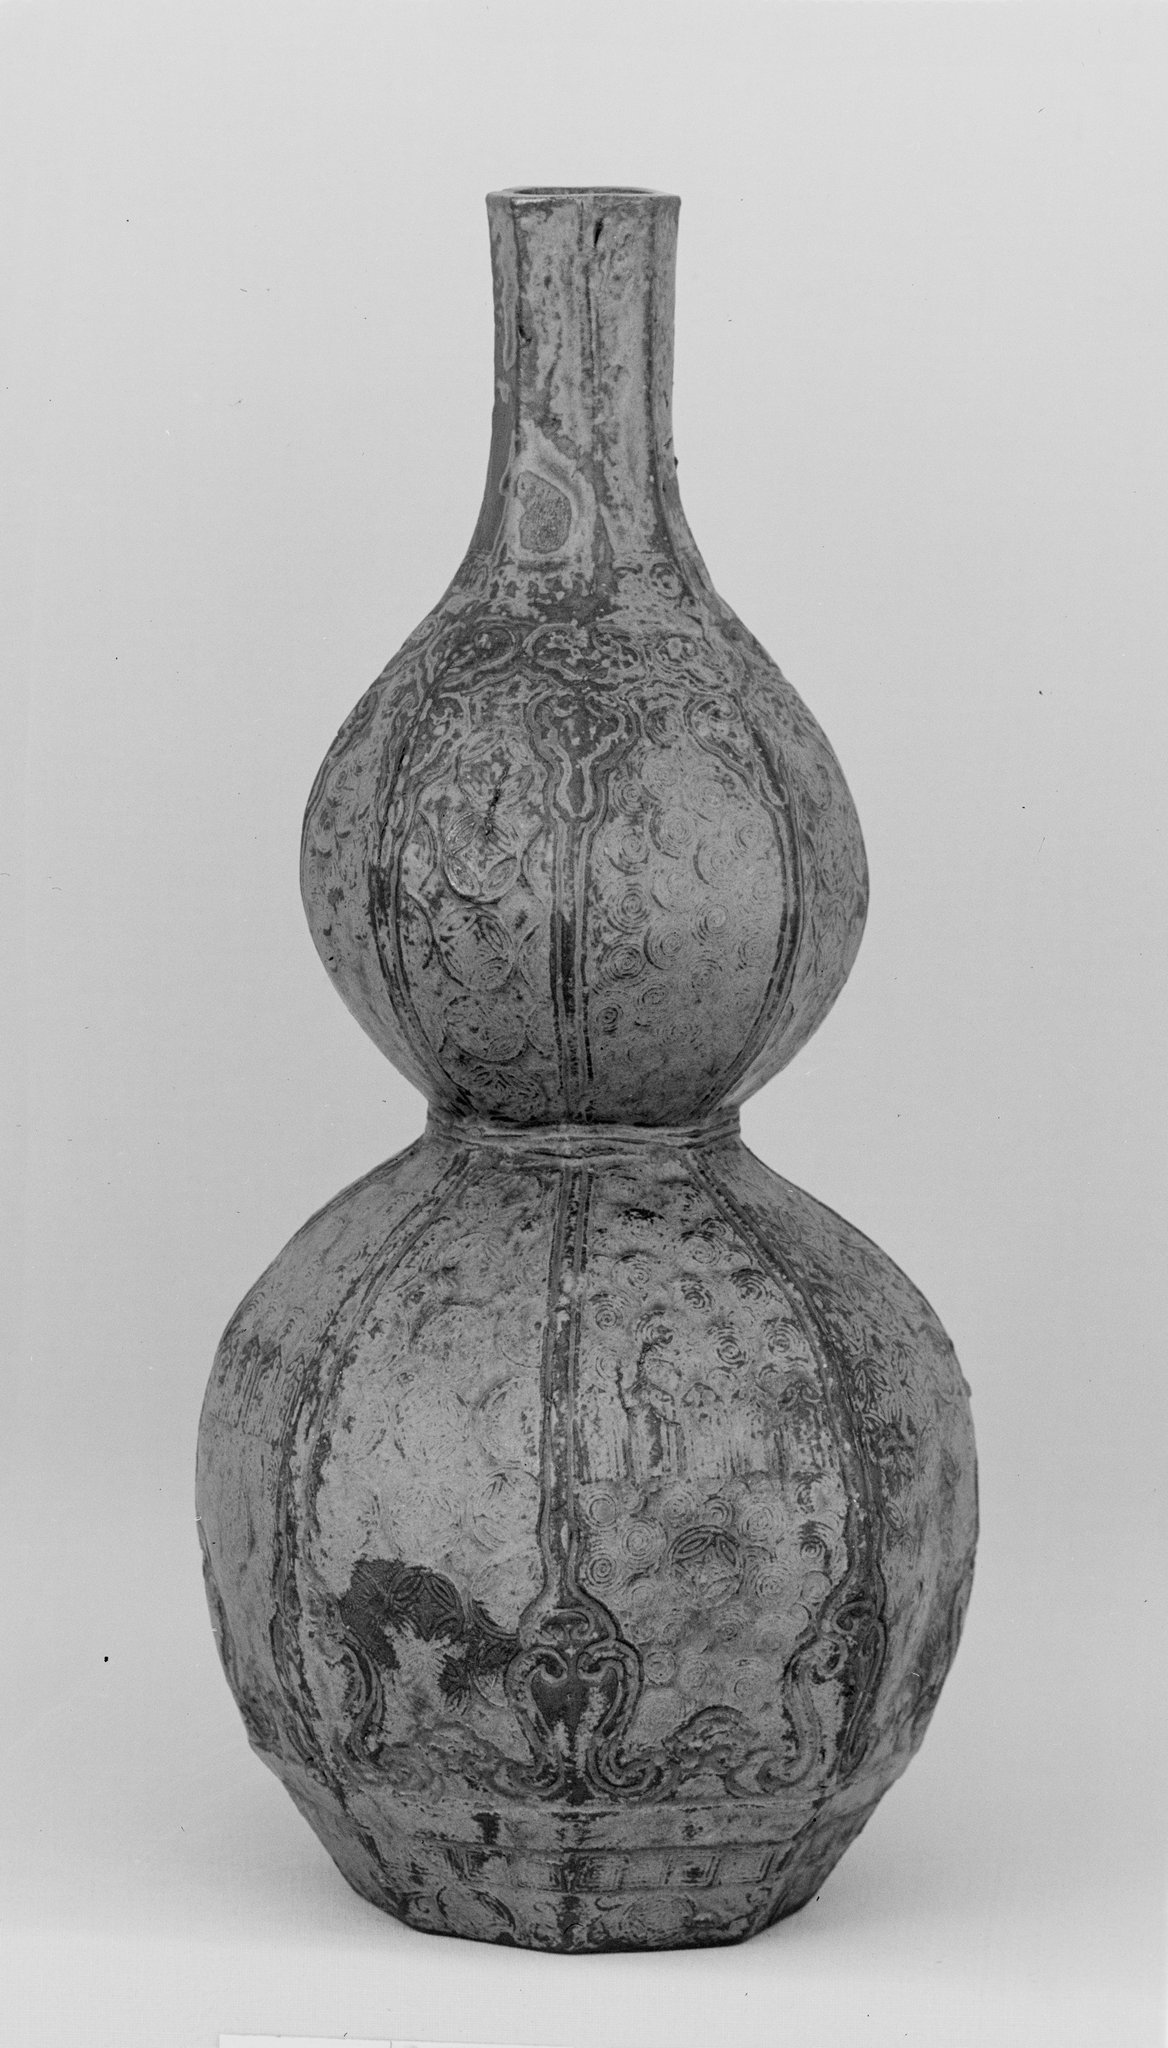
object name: bottle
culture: japanese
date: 1700-1750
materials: glaze, paste, pottery